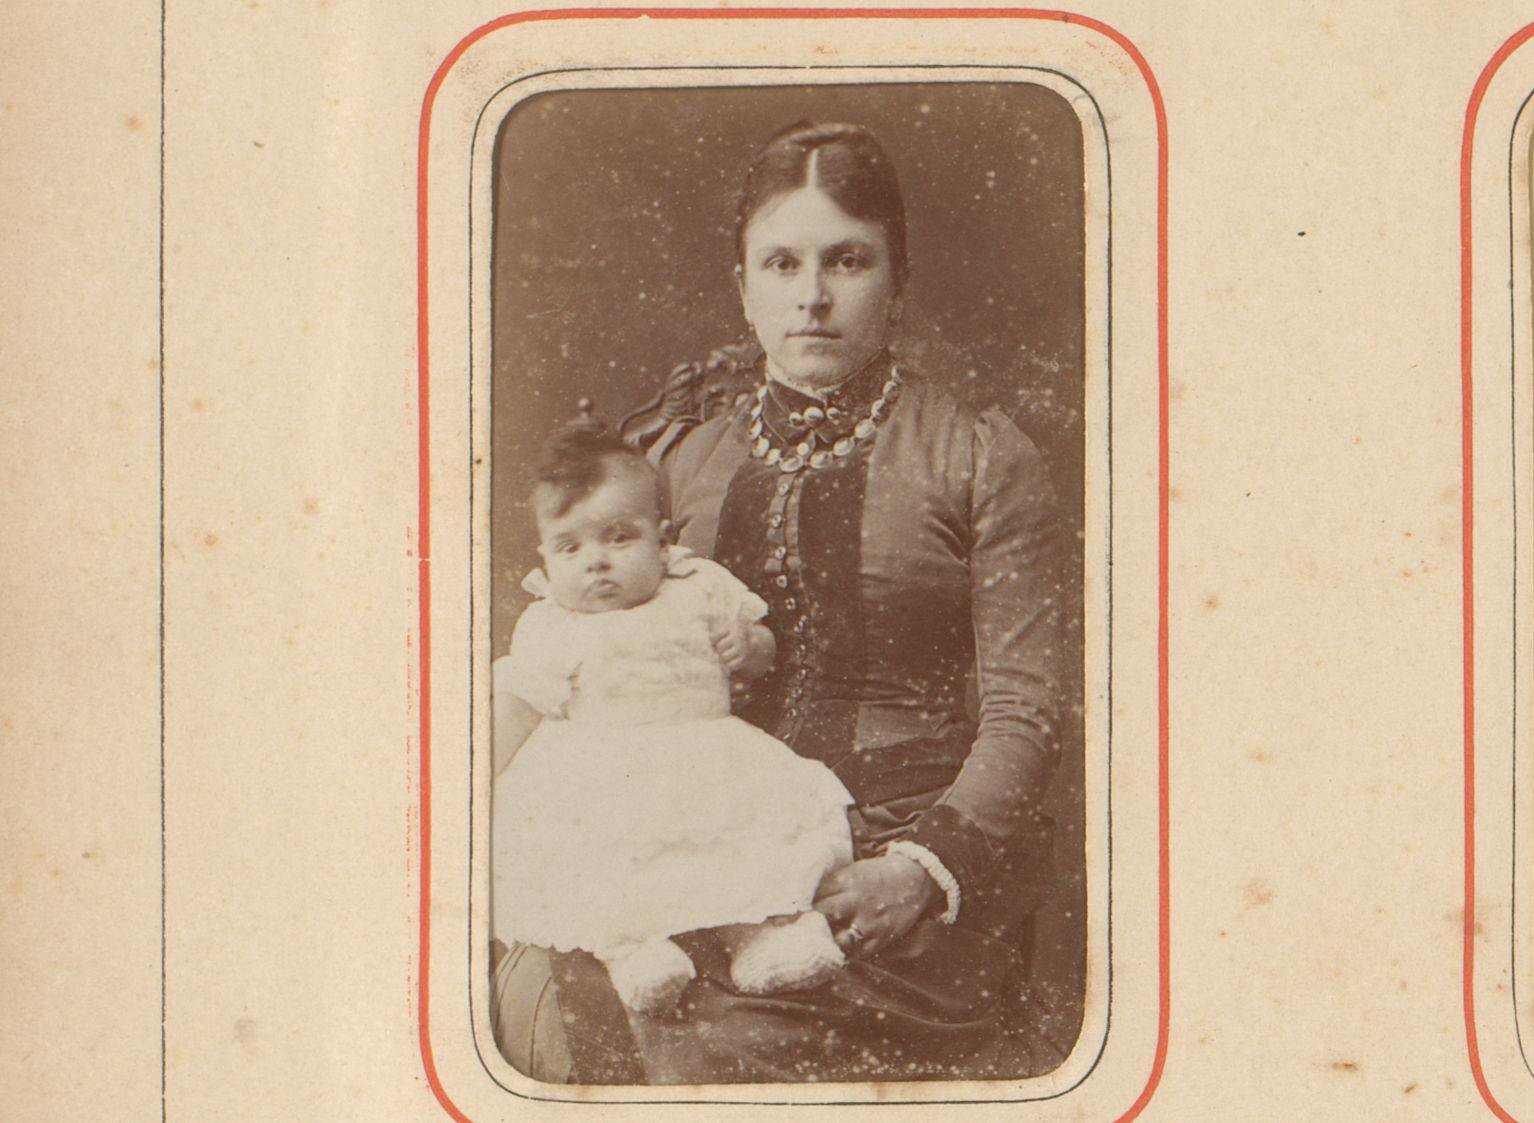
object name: carte de visite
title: Portret van een onbekende moeder met baby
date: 1877-1884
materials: cardboard, paper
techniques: albumen print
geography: amsterdam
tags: anonymous historical person portrayed, mother and baby or young child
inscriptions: address: ‘128. P.C. HOOFTSTRAAT/ Amsterdam’